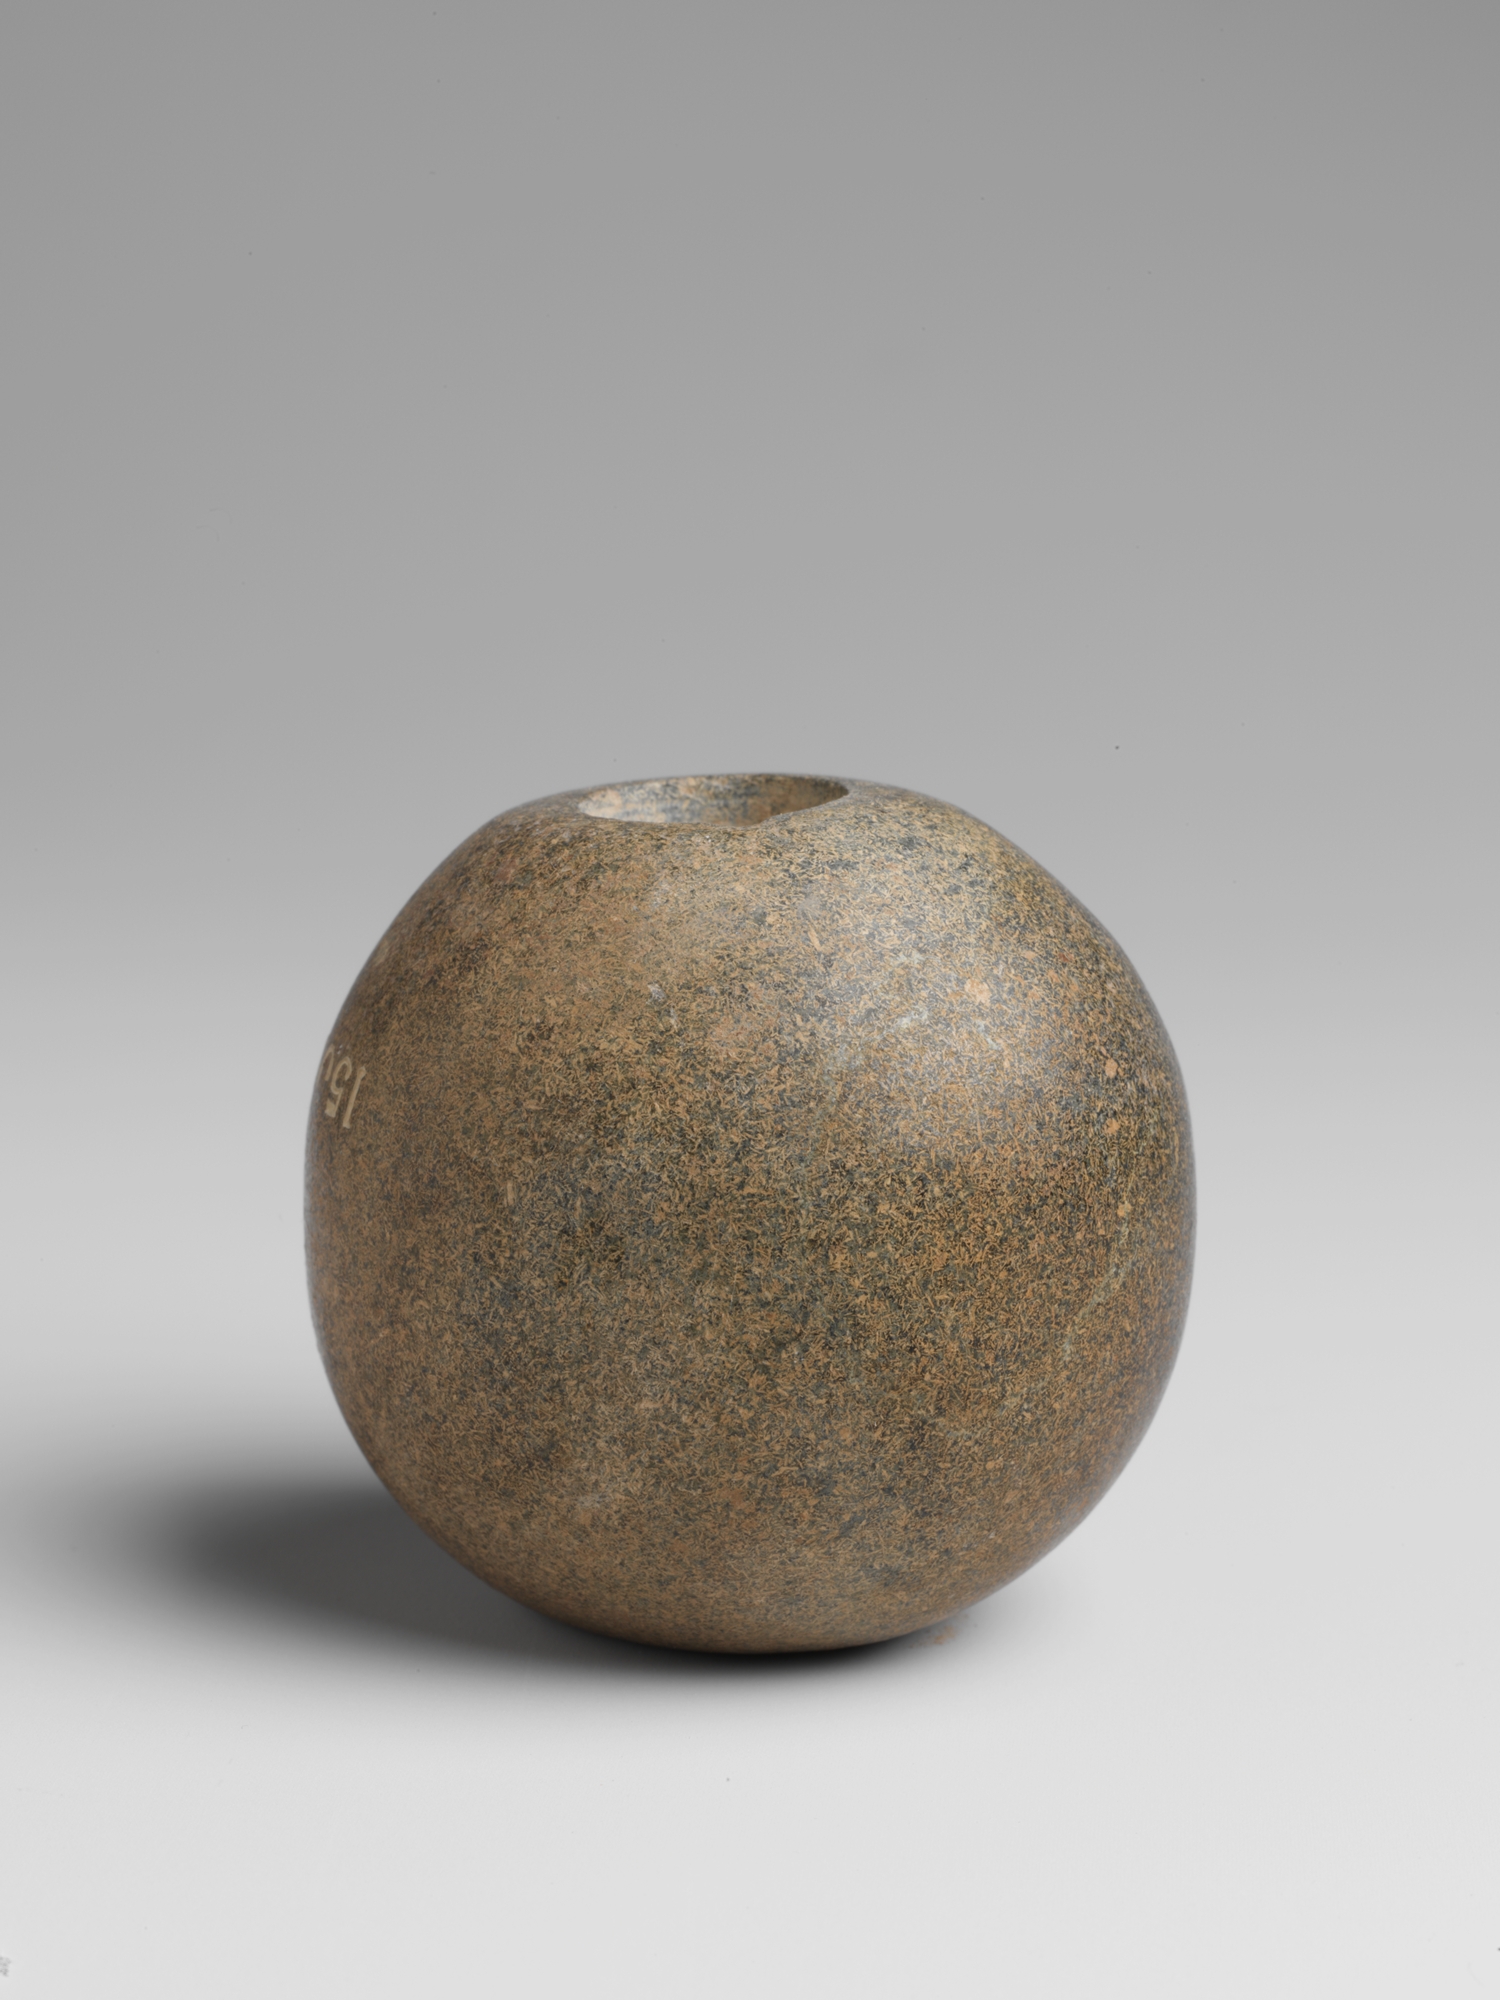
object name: mace head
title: Gabbro mace head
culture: cypriot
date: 2500-1900 BCE